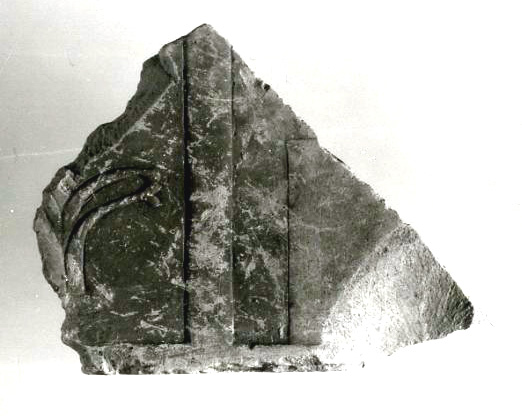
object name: relief fragment, tomb of meketre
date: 1981-1975 BCE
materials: limestone, paint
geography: egypt